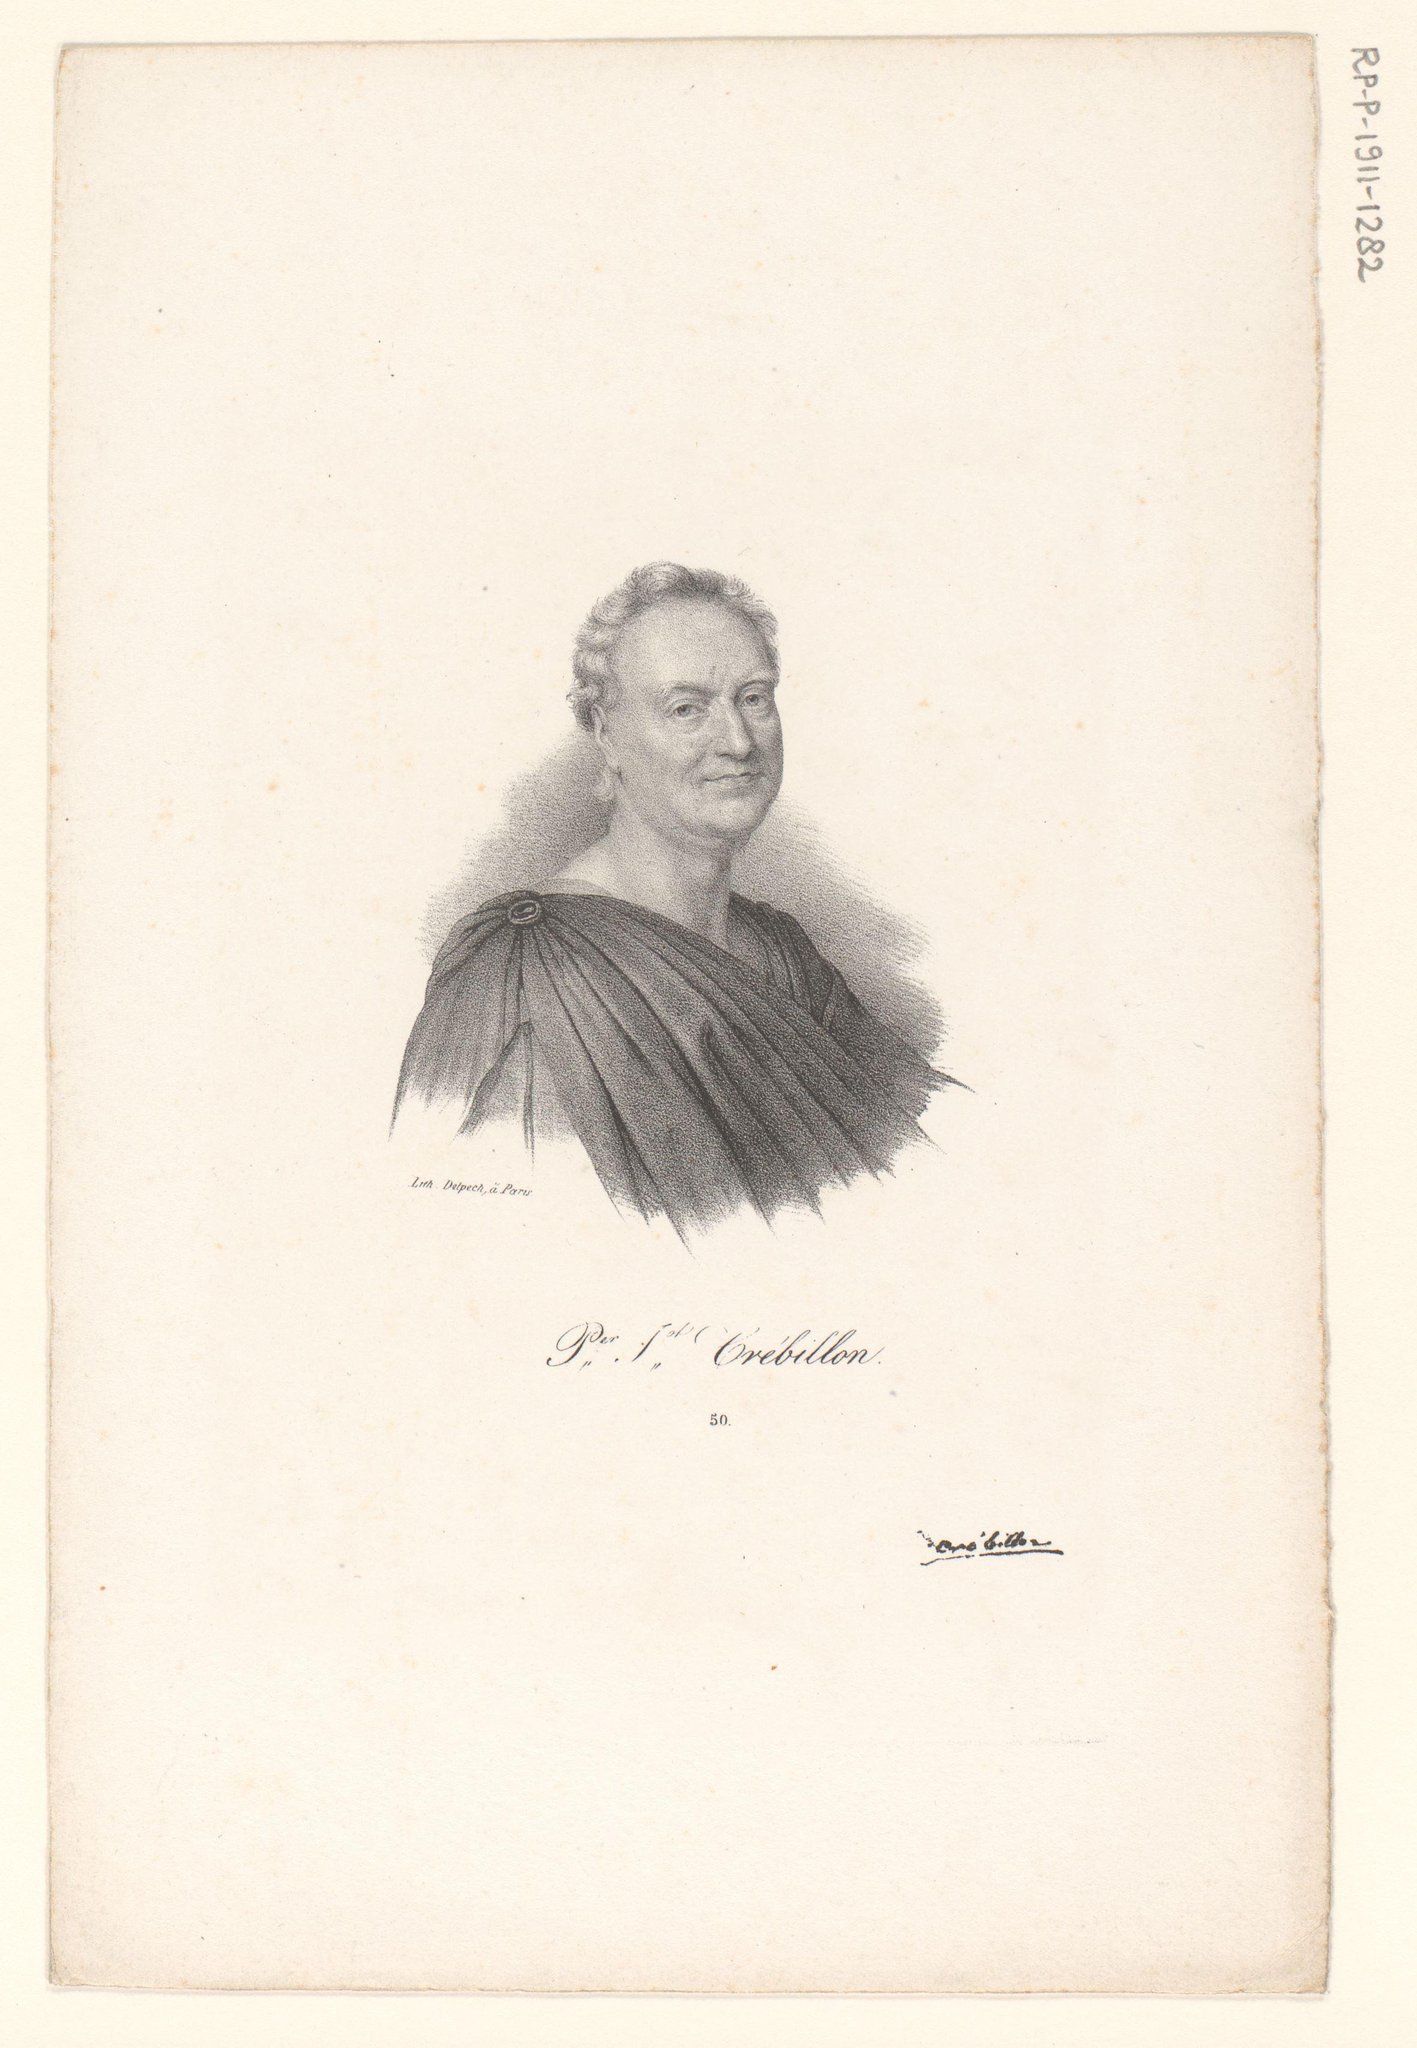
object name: print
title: Portret van Prosper Jolyot de Crébillon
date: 1818-1842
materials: paper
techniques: lithograph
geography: paris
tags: historical persons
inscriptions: collector's mark: Lugt 2228a